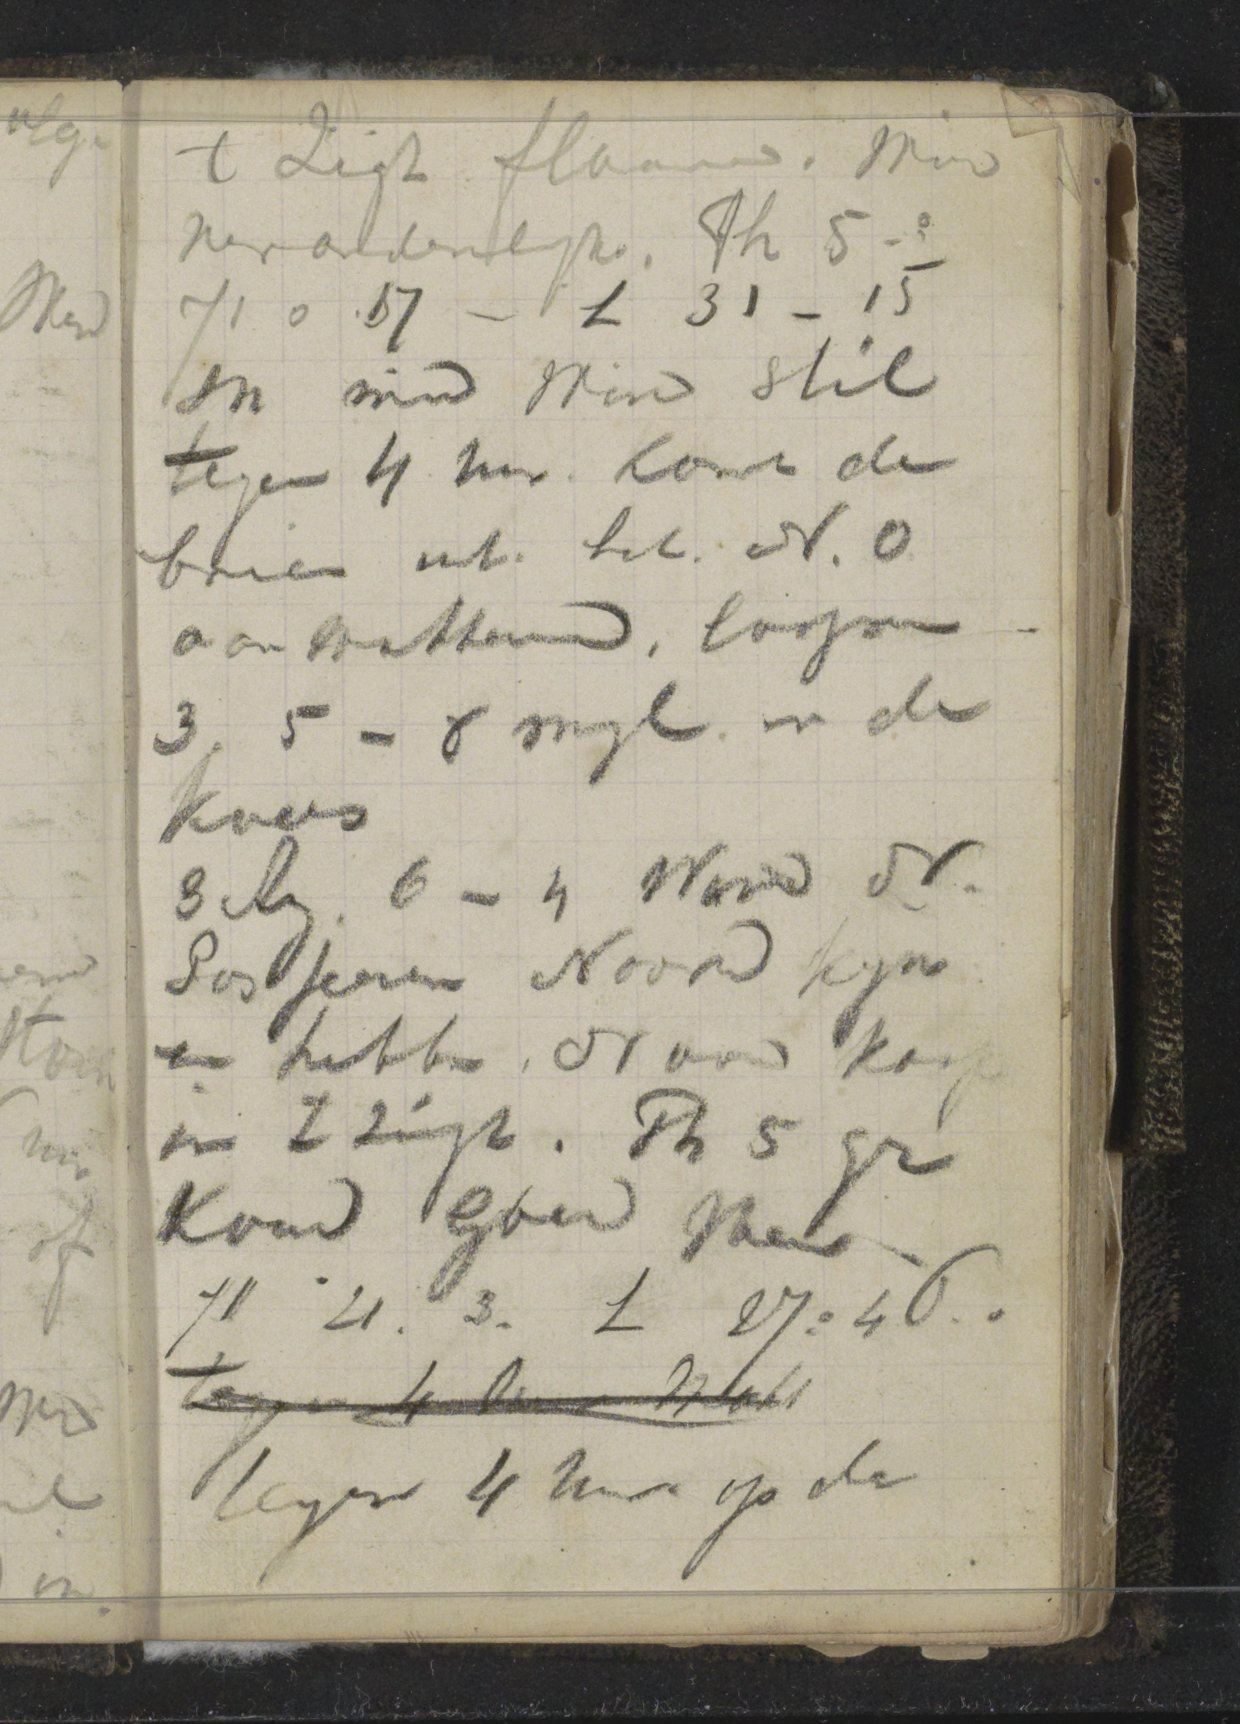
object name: sketchbook leaf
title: Reisverslag van begin september 1880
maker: louis apol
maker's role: draughtsman, painter, print maker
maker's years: 1850-1936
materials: chalk, pencil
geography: novaya zemlya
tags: nova zembla expedities 1880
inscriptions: annotation: ‘[...]’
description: Blad 36 recto uit een schetsboek met 110 bladen betekend tijdens de expeditie naar Nova Zembla in 1880.